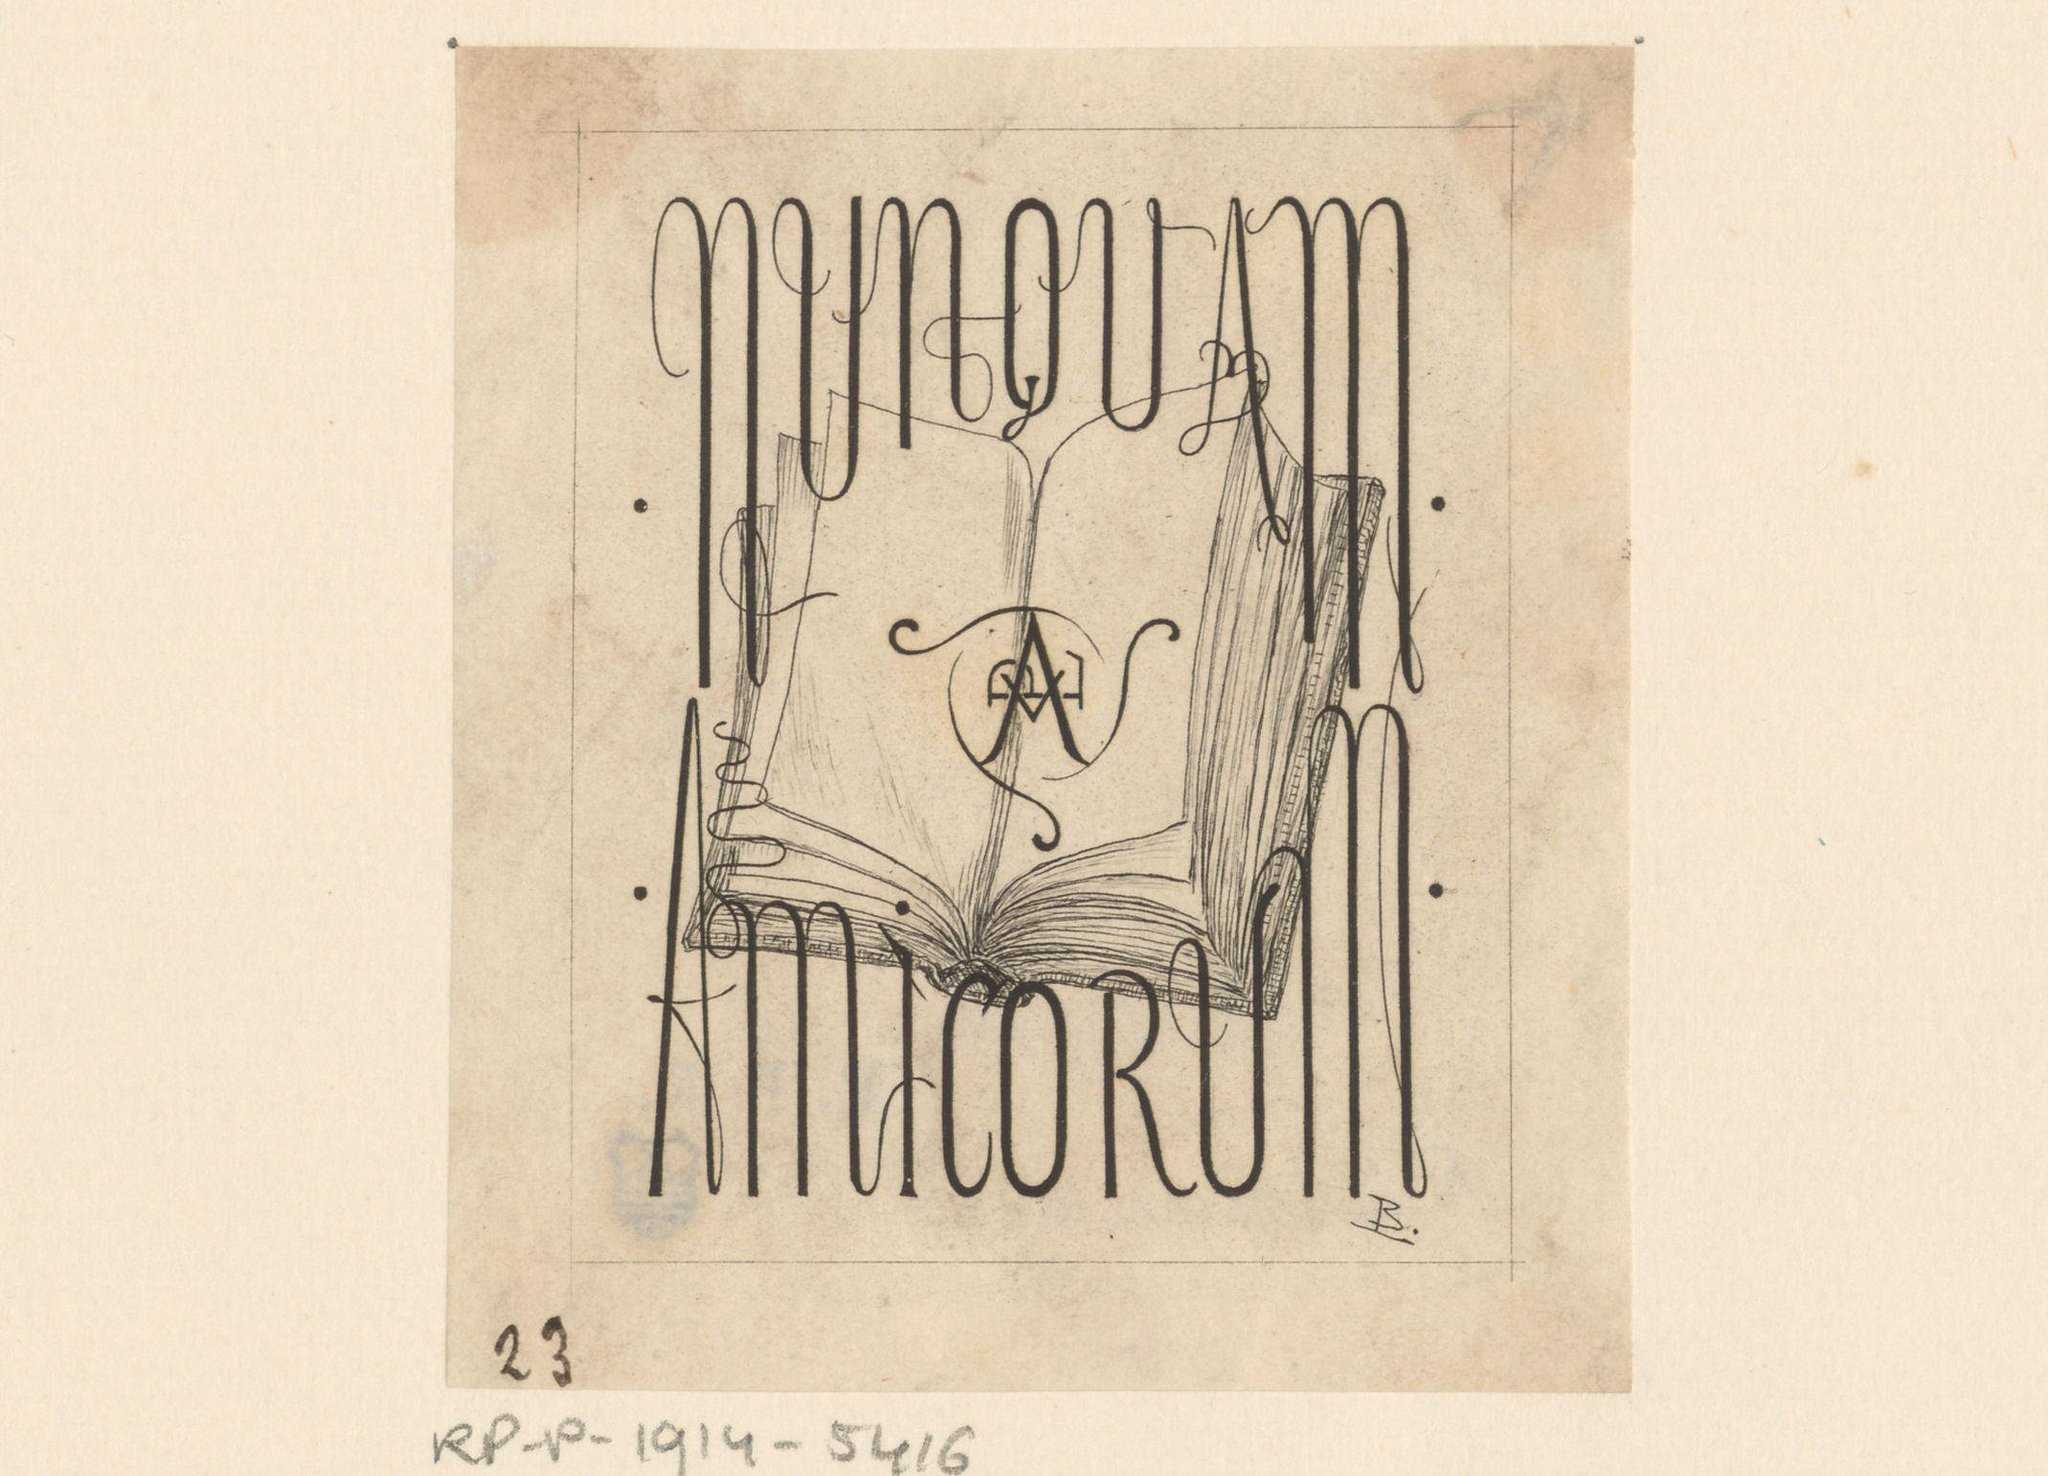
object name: bookplate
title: Nunquam amicorum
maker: félix bracquemond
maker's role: print maker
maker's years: 1833-1914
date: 1843-1878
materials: paper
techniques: etching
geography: france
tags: book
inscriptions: collector's mark: Lugt 2233, collector's mark: Lugt 2760, inscription: ‘23’